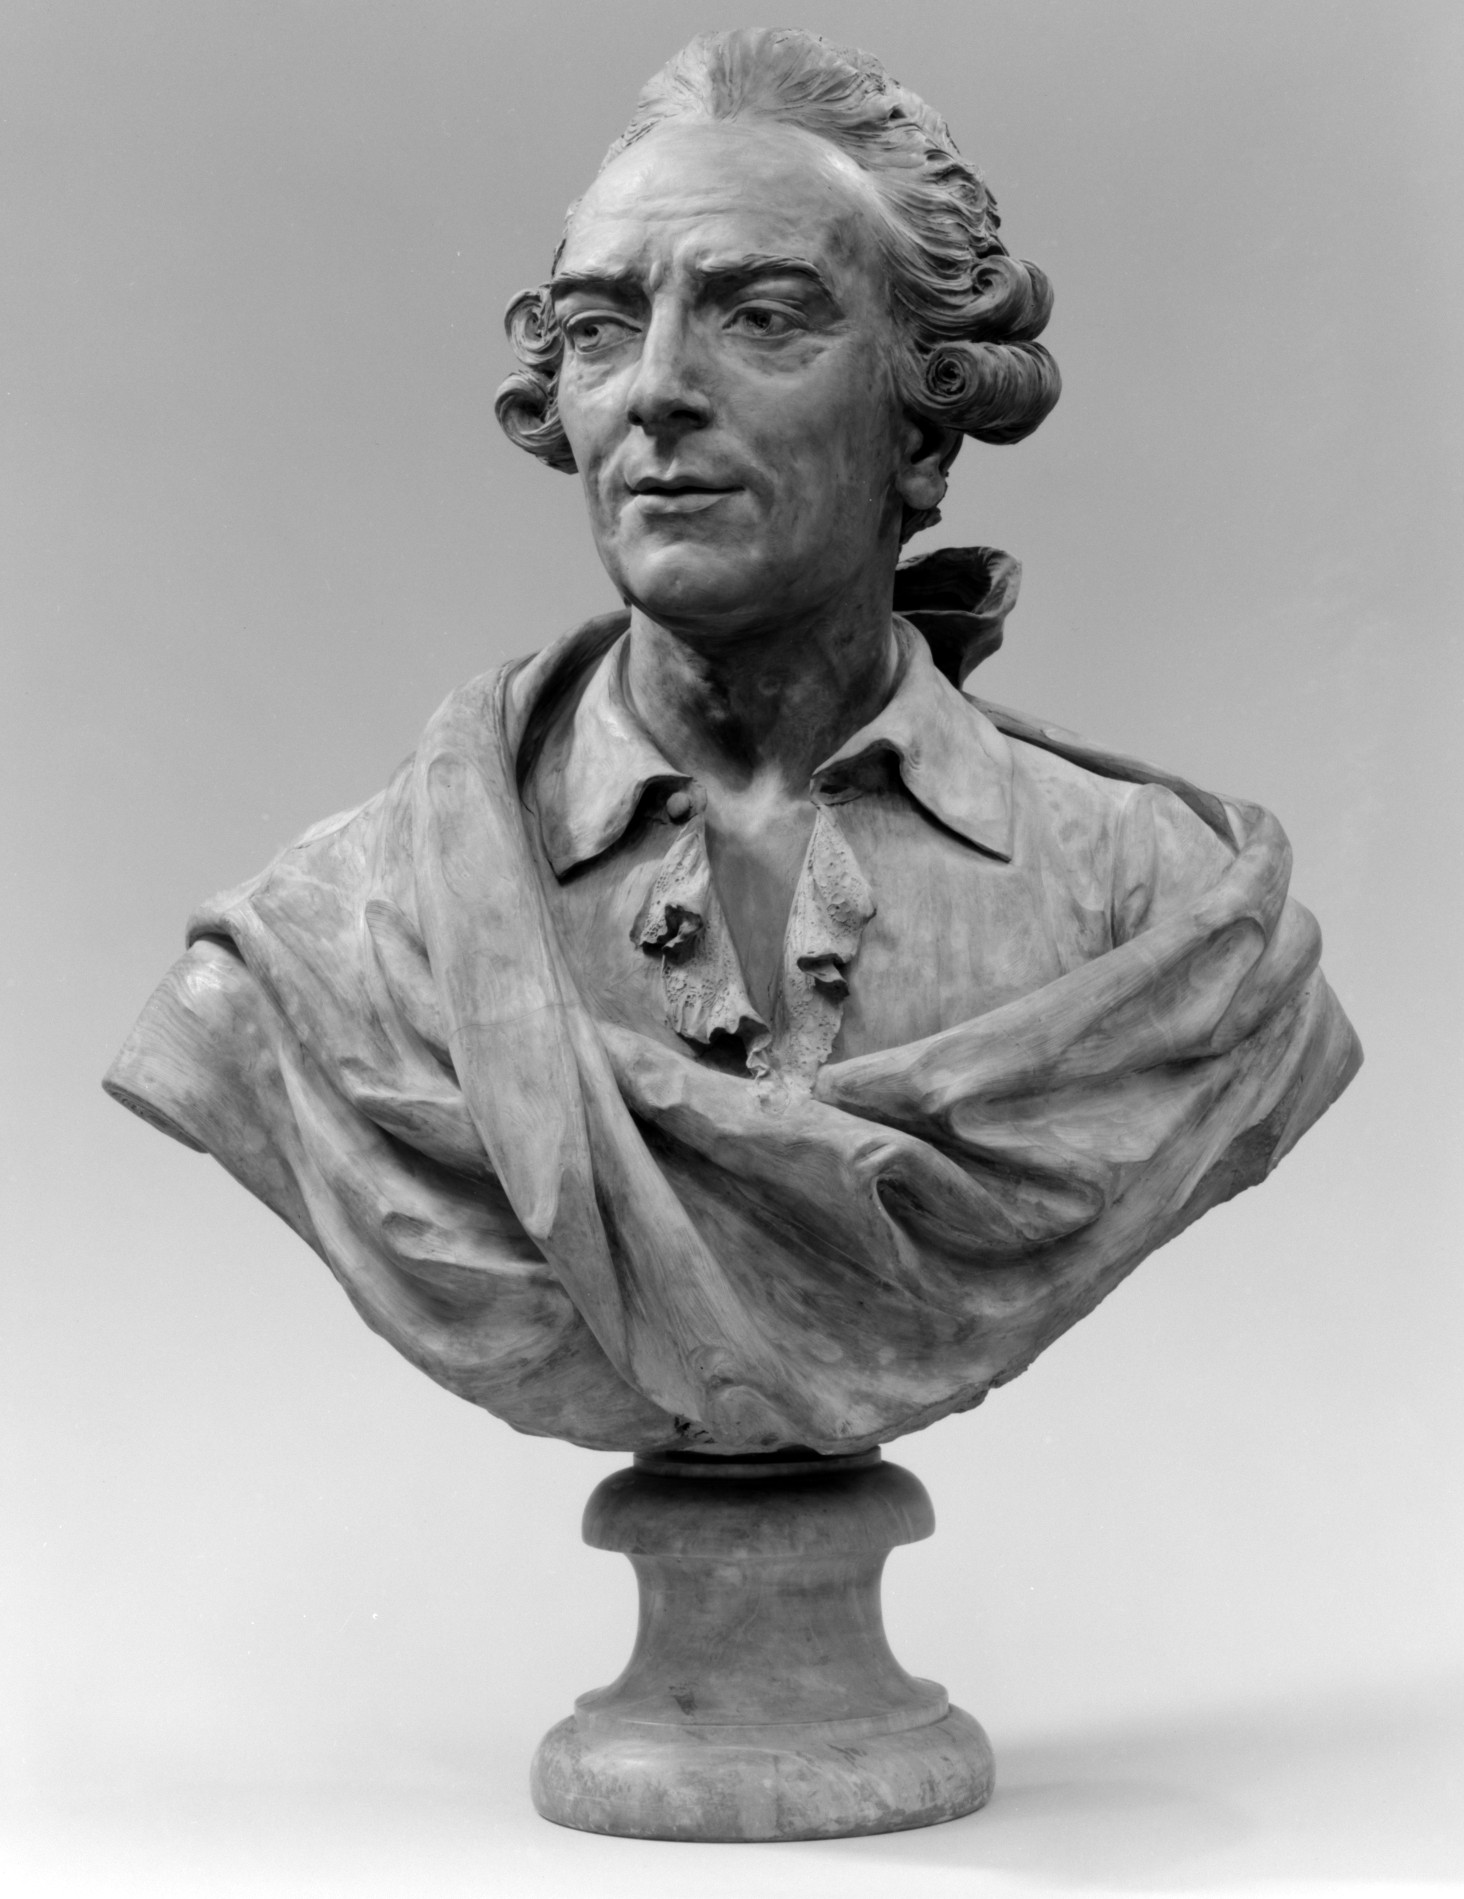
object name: bust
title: Pierre François Basan (1723–1797)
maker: augustin pajou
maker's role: artist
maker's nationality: french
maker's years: 1730-1809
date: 1901-2000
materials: terracotta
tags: men,portraits